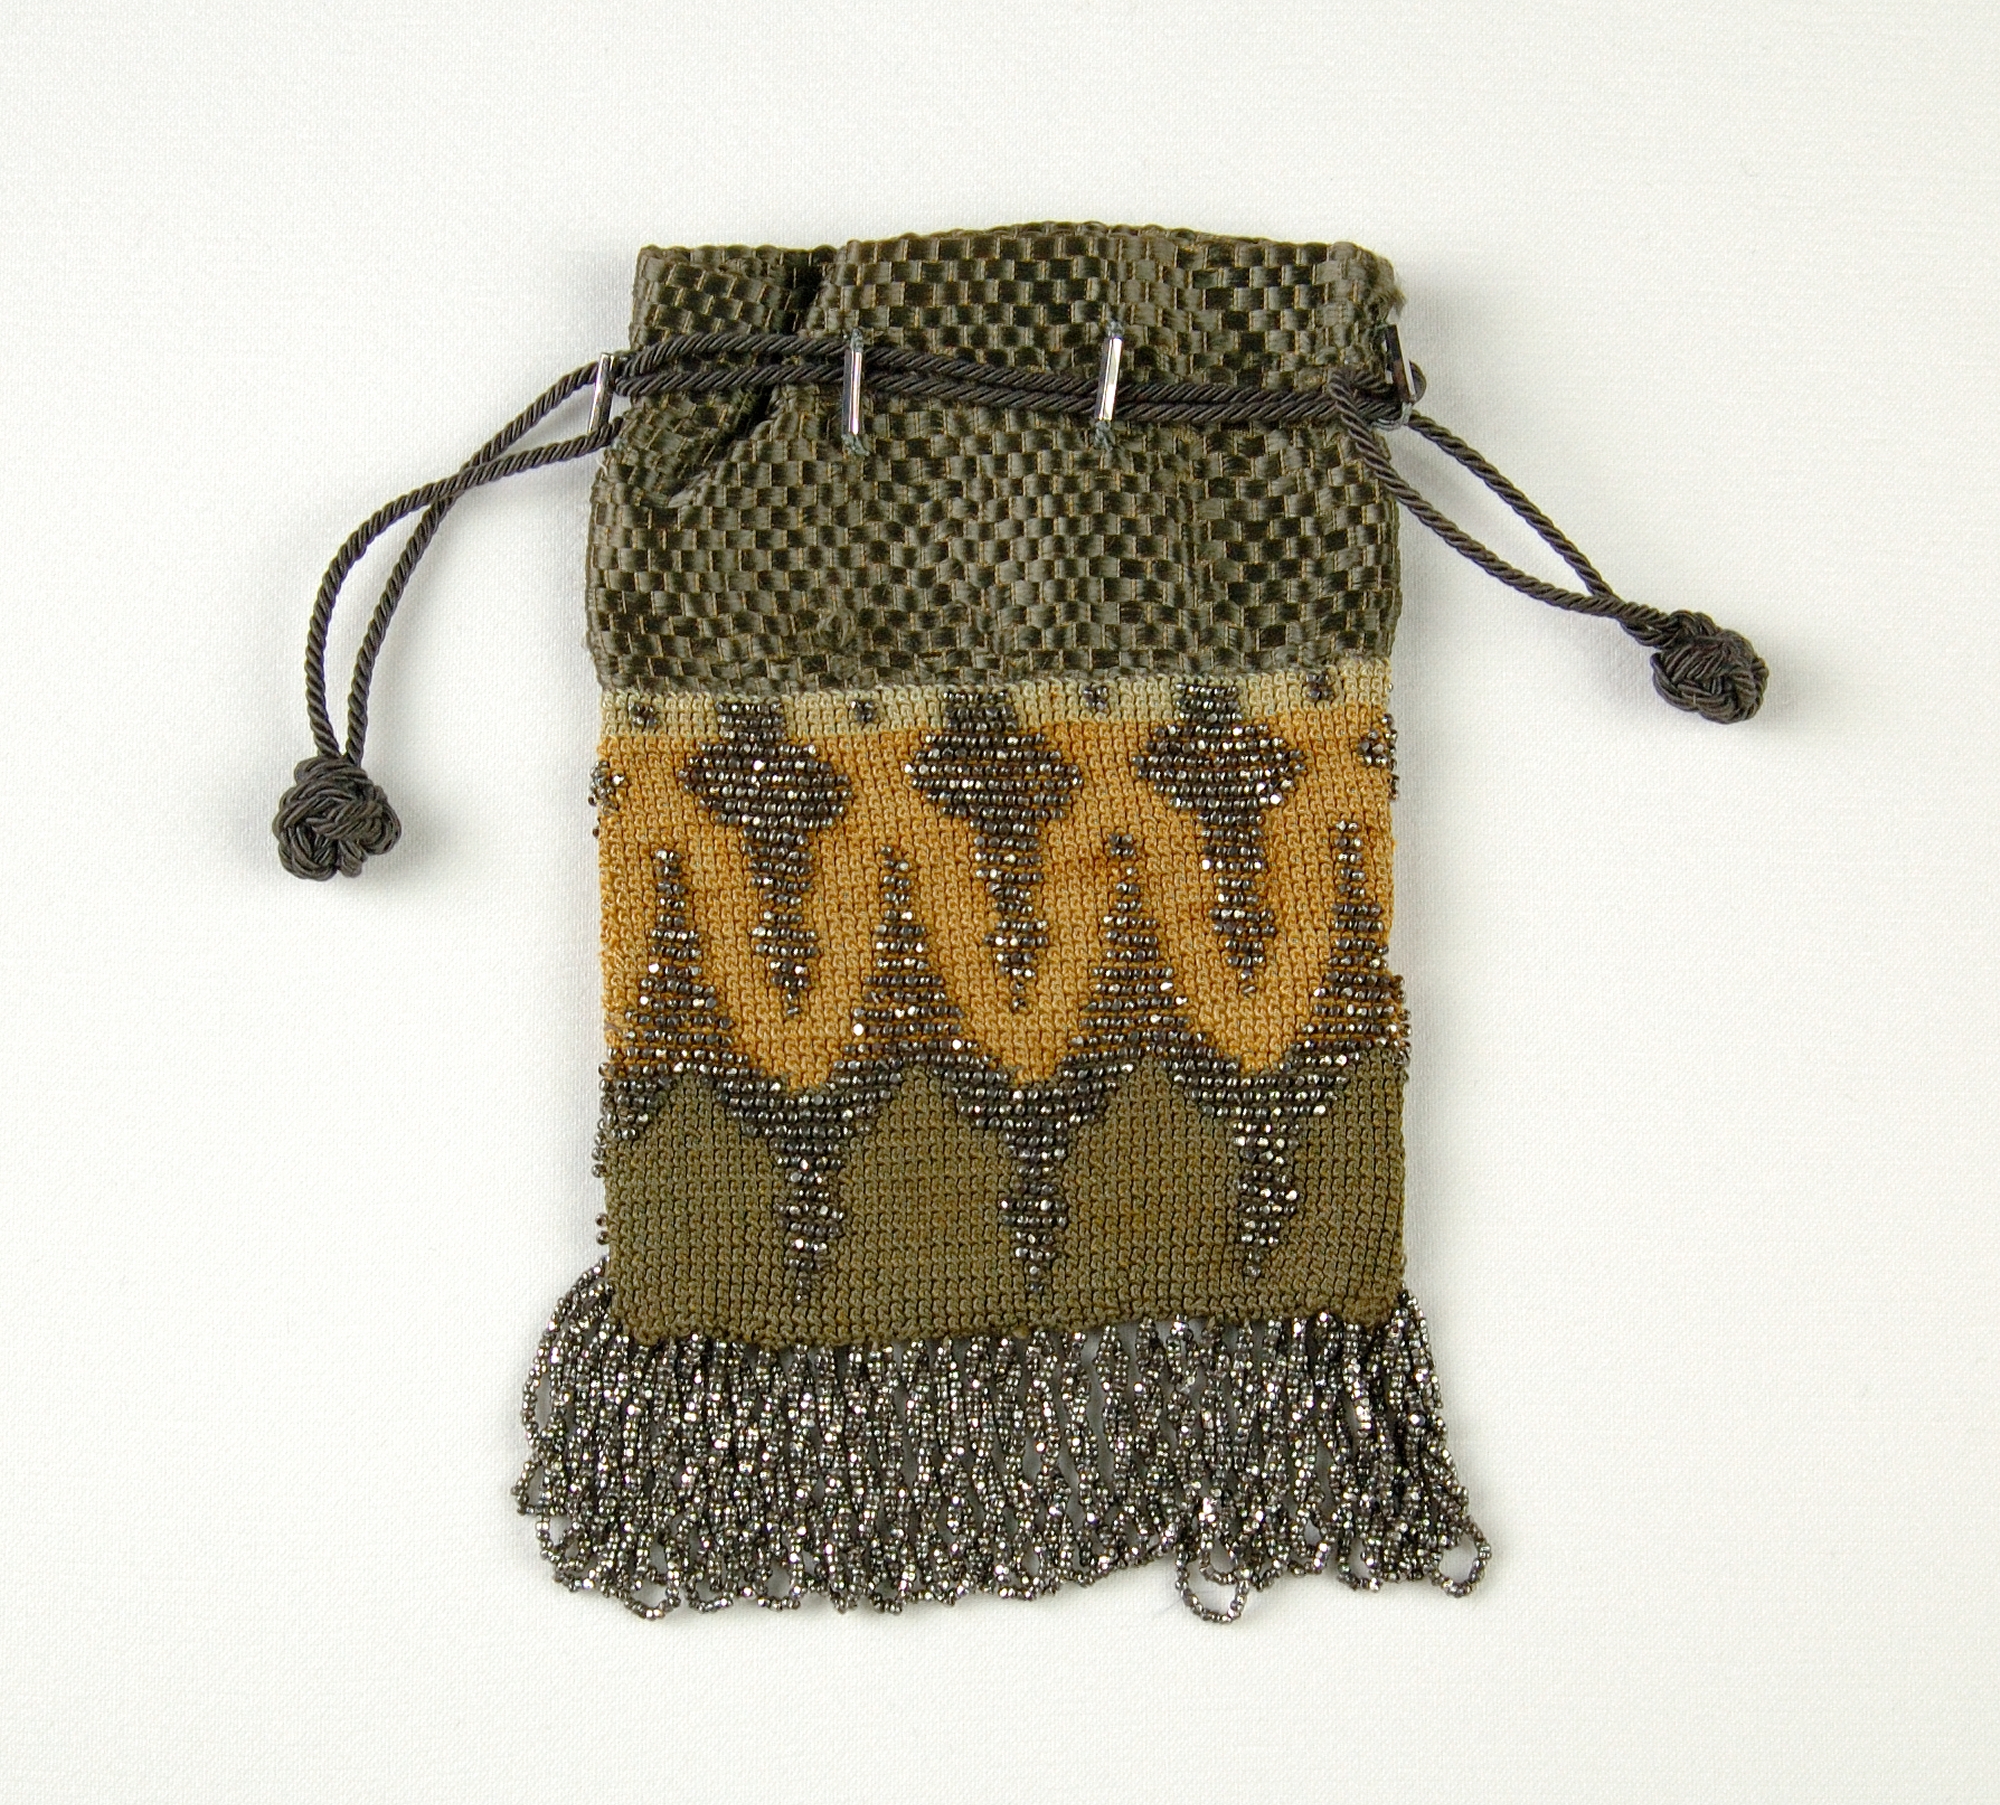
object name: pouch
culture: american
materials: metal, silk